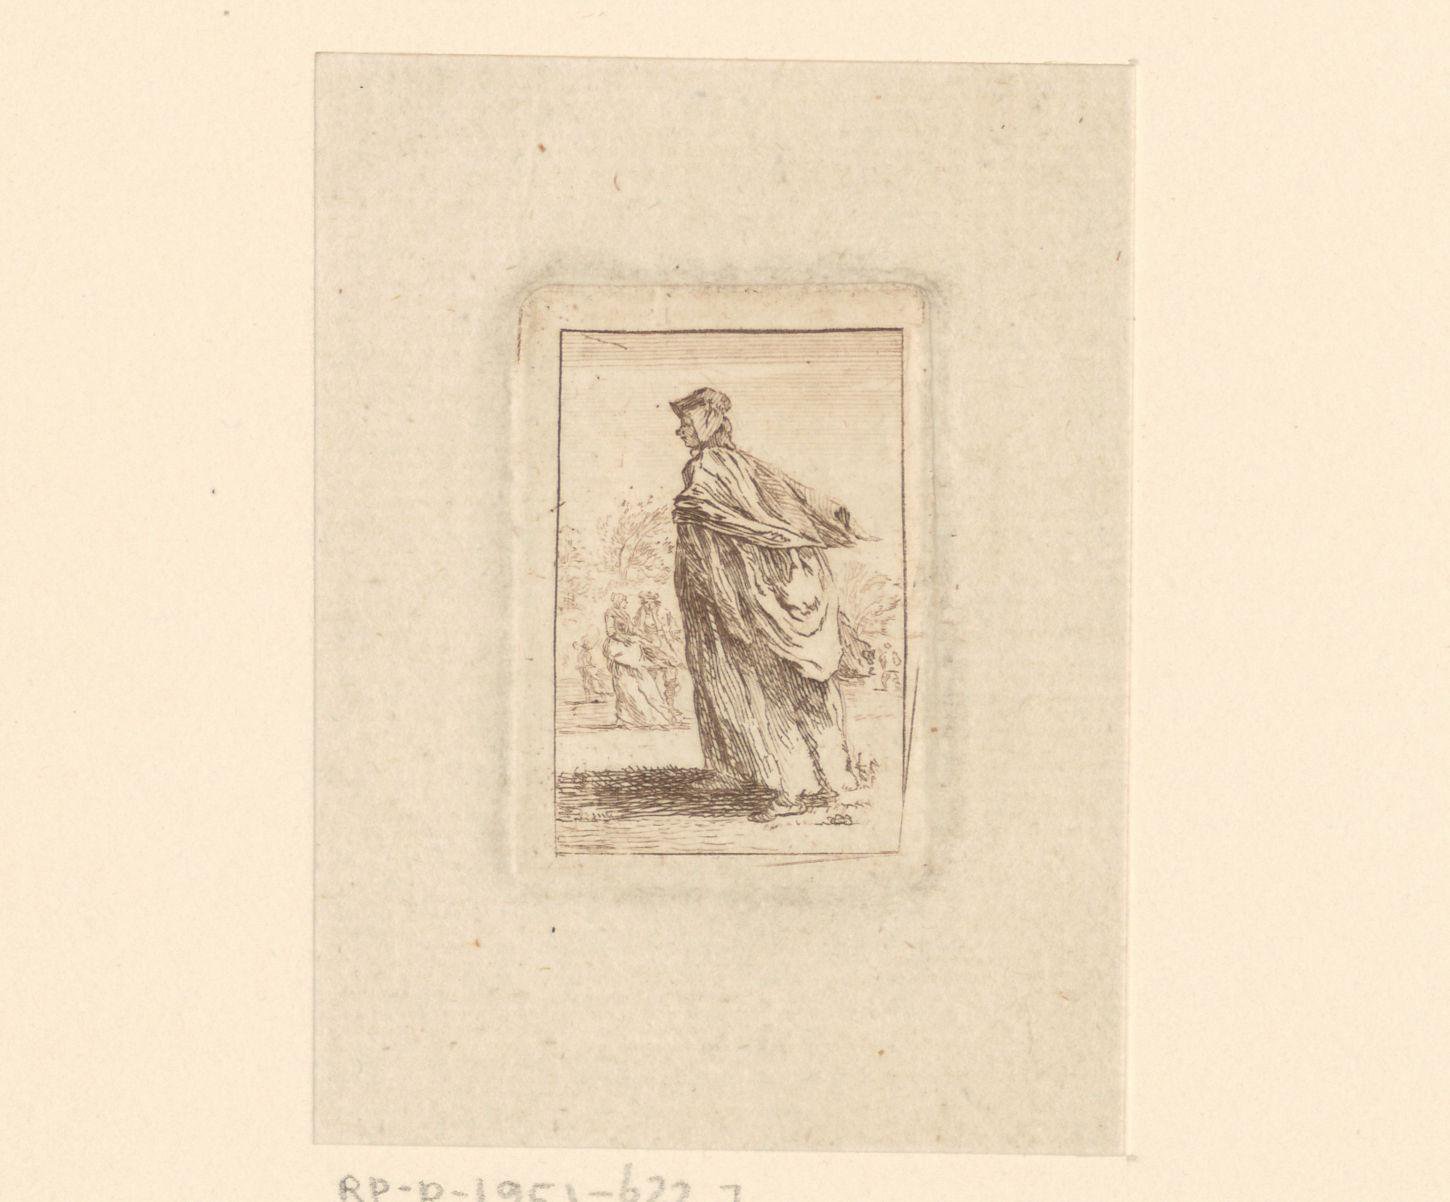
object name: print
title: Figure Subjects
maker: paul sandby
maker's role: draughtsman, print maker, publisher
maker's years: 1725-1809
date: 1735-1809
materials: paper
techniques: etching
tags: adult woman, coat, cape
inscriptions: collector's mark: Lugt 2228